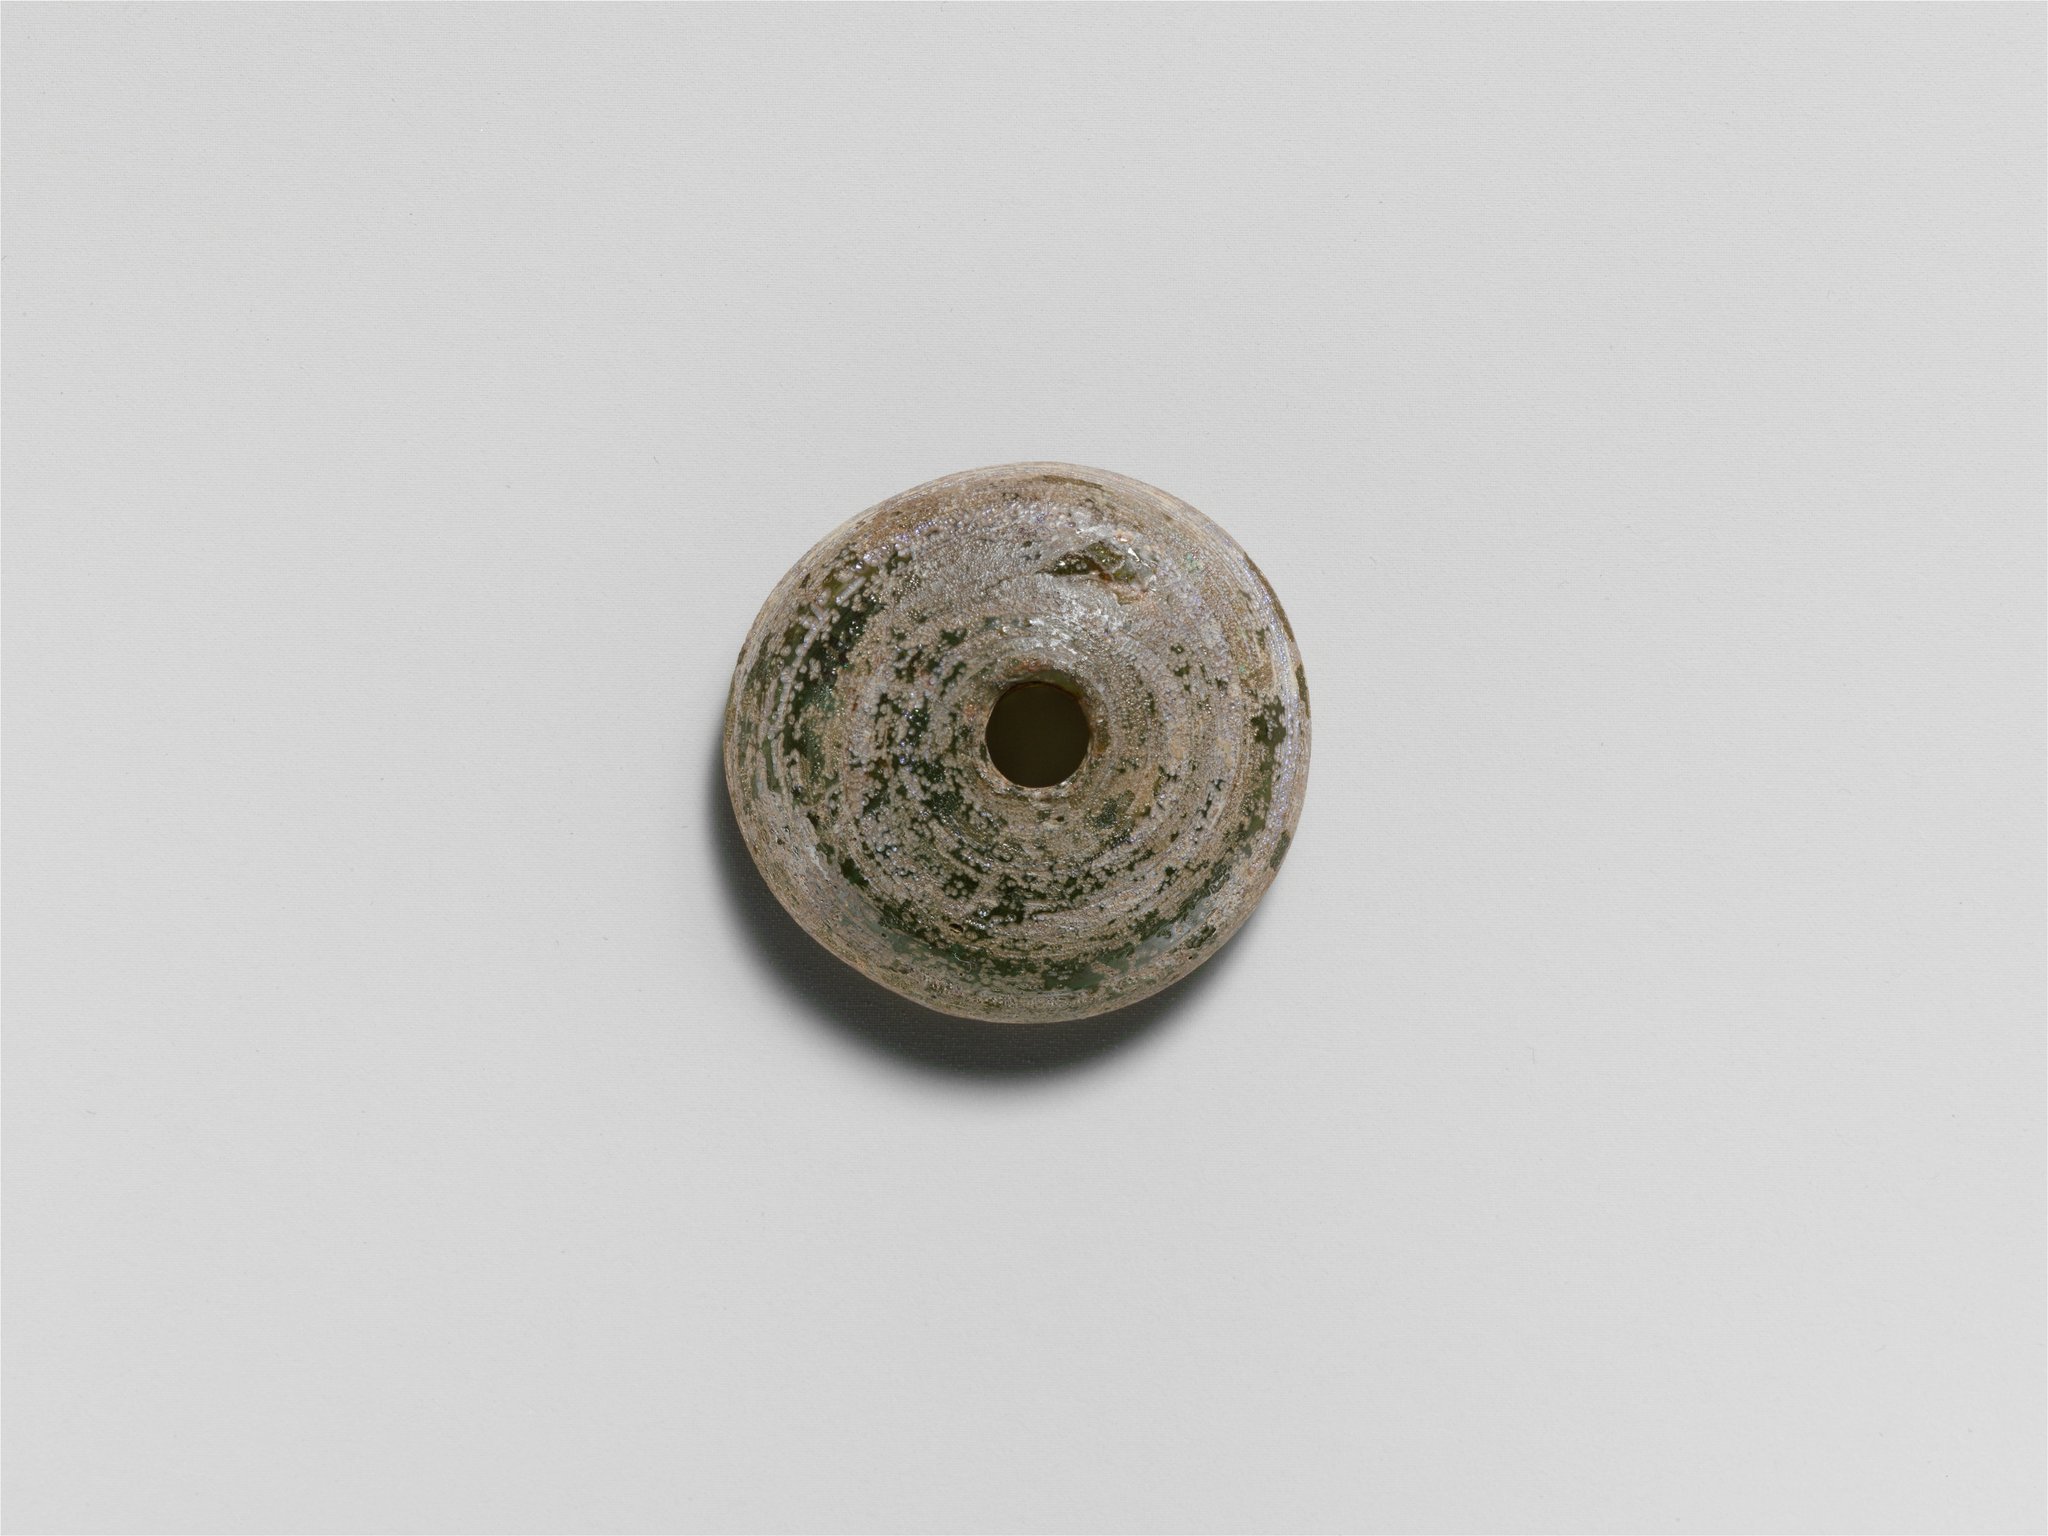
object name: spindle whorl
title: Glass spindle whorl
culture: roman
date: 1-300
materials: glass